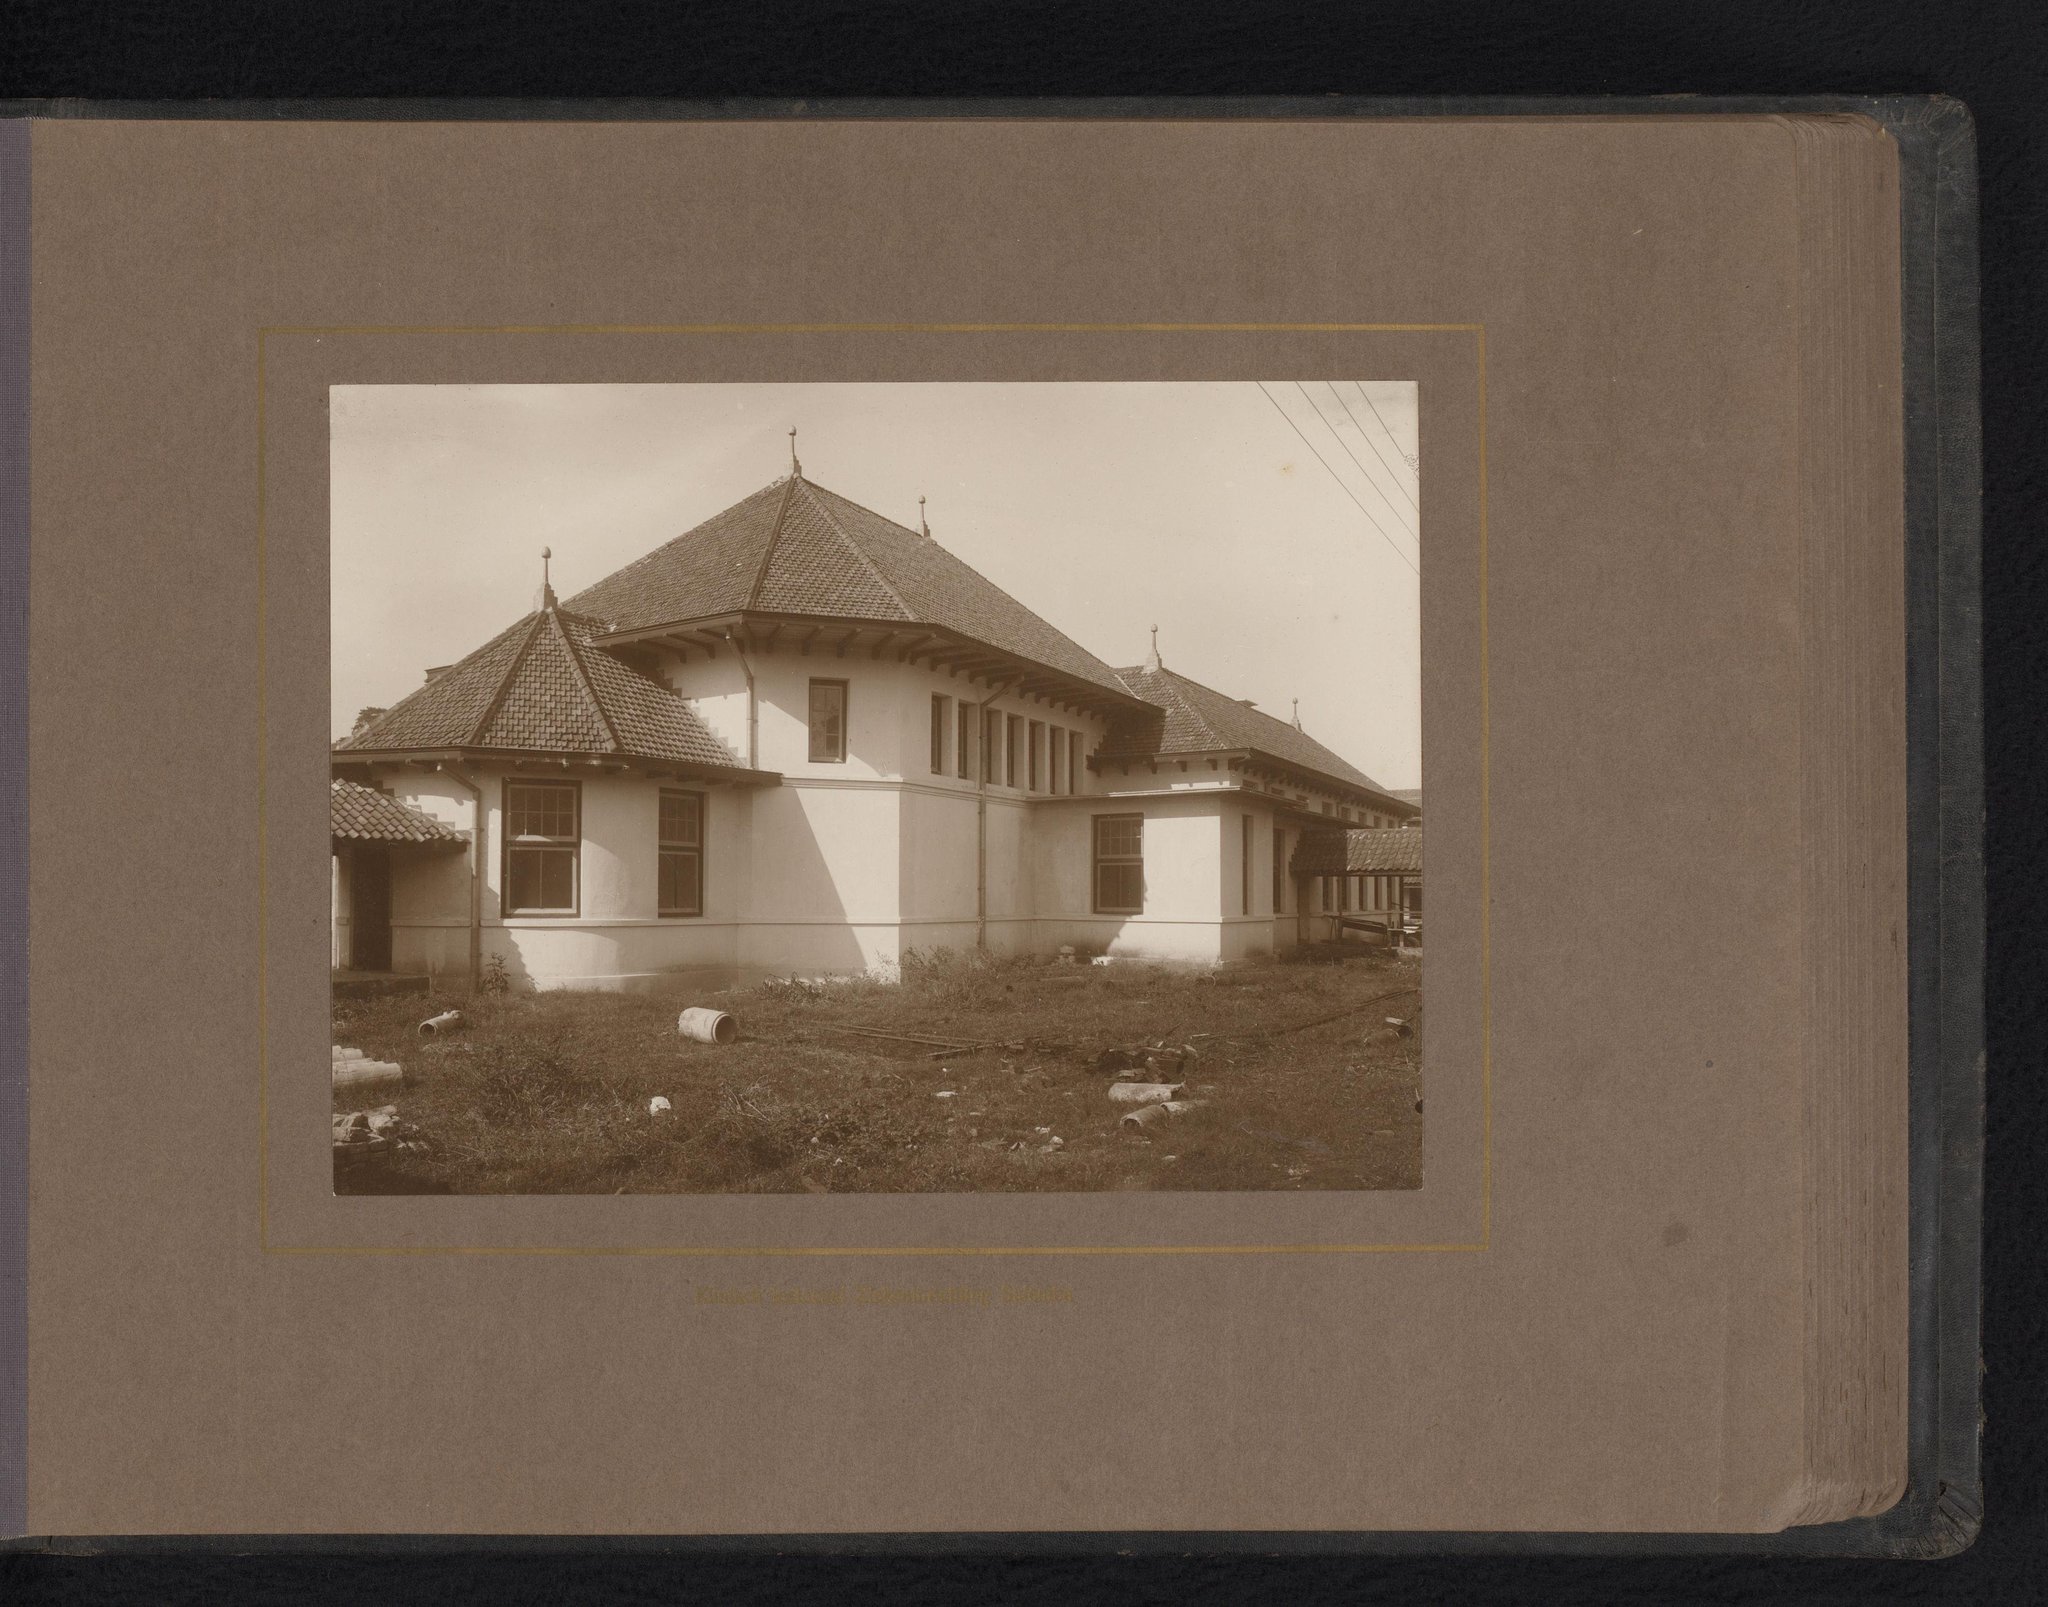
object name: photograph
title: Klinisch leslocaal Ziekeninrichting Salemba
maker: Anonymous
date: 1918-1919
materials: photographic support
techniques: gelatin silver print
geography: batavia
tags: further education (+ building ~ education, tuition), hospital, batavia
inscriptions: inscription: ‘Klinisch leslocaal Ziekeninrichting Salemba’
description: Het klinisch leslokaal van het ziekenhuis de Centrale Burgerlijke Ziekeninrichting op Salemba, Weltevreden. Onderdeel van het fotoalbum van de Eerste Waterstaatsafdeling op West-Java 22 maart 1915 - 30 juli 1919.